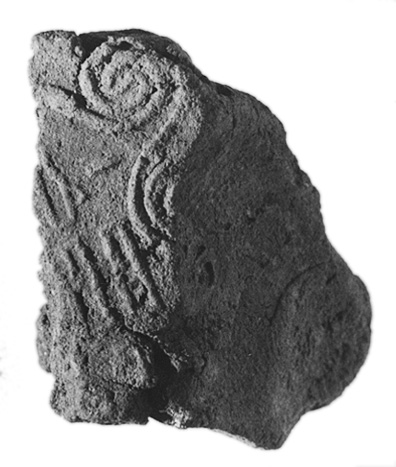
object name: sealing fragment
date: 2030-1640 BCE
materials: clay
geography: egypt